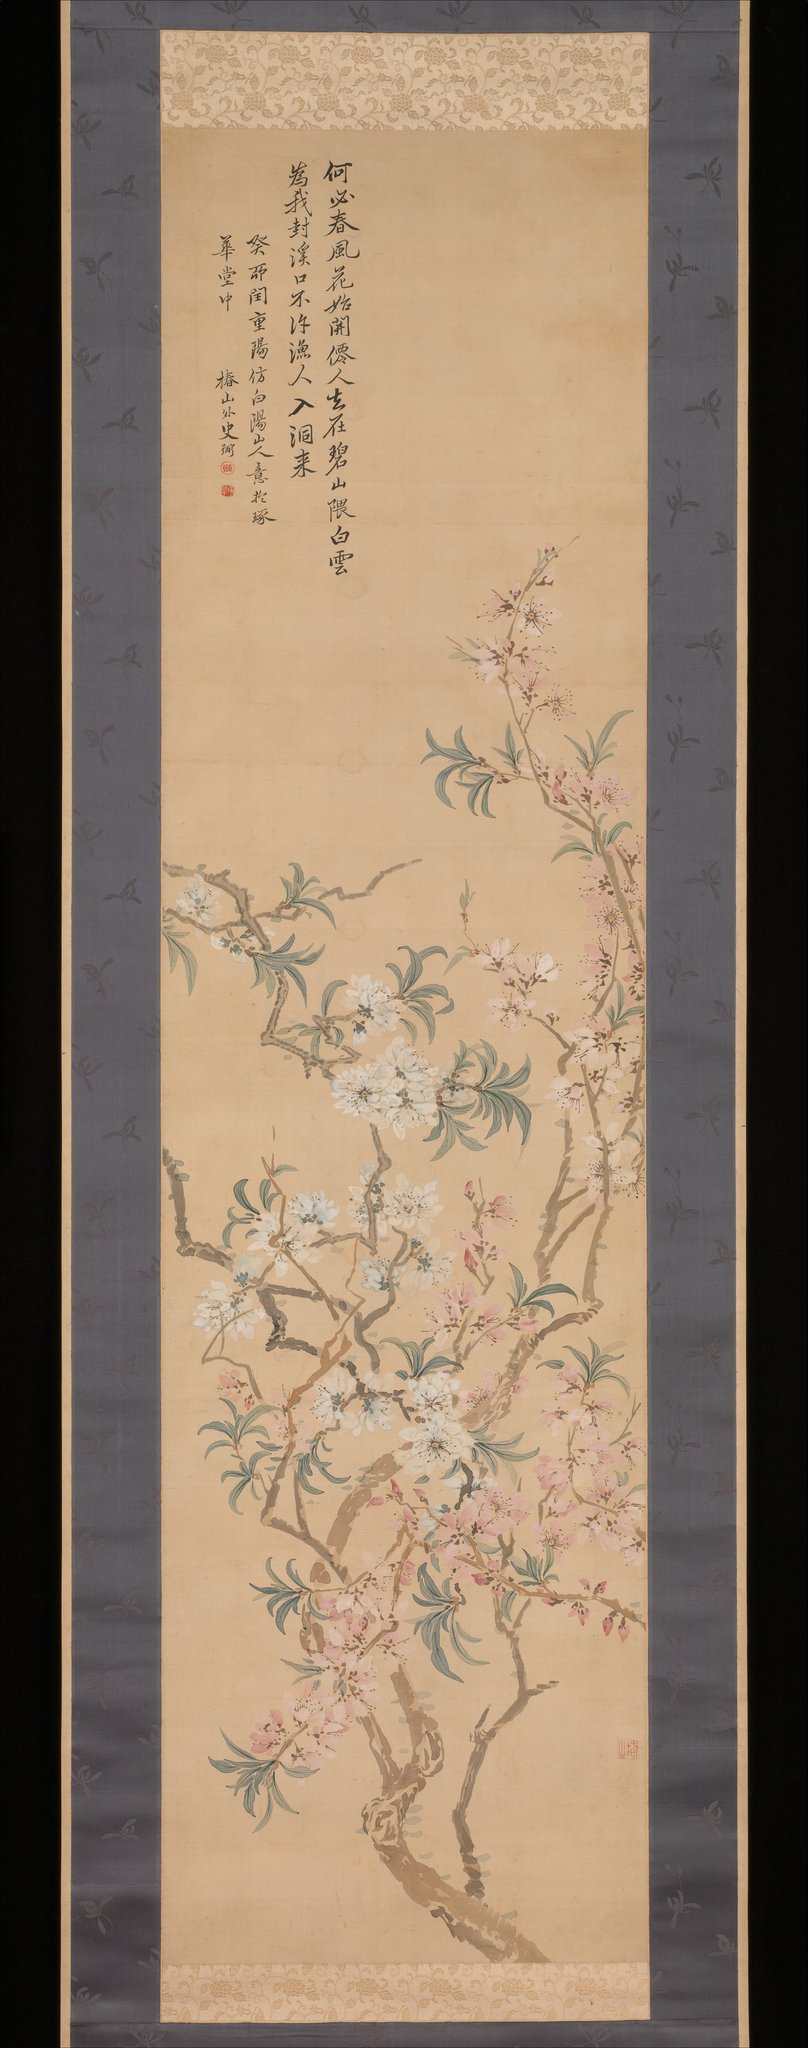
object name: hanging scroll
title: Red and White Peach Blossoms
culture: japanese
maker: tsubaki chinzan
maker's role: artist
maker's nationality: japanese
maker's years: 1801-1854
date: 1843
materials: paper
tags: flowers